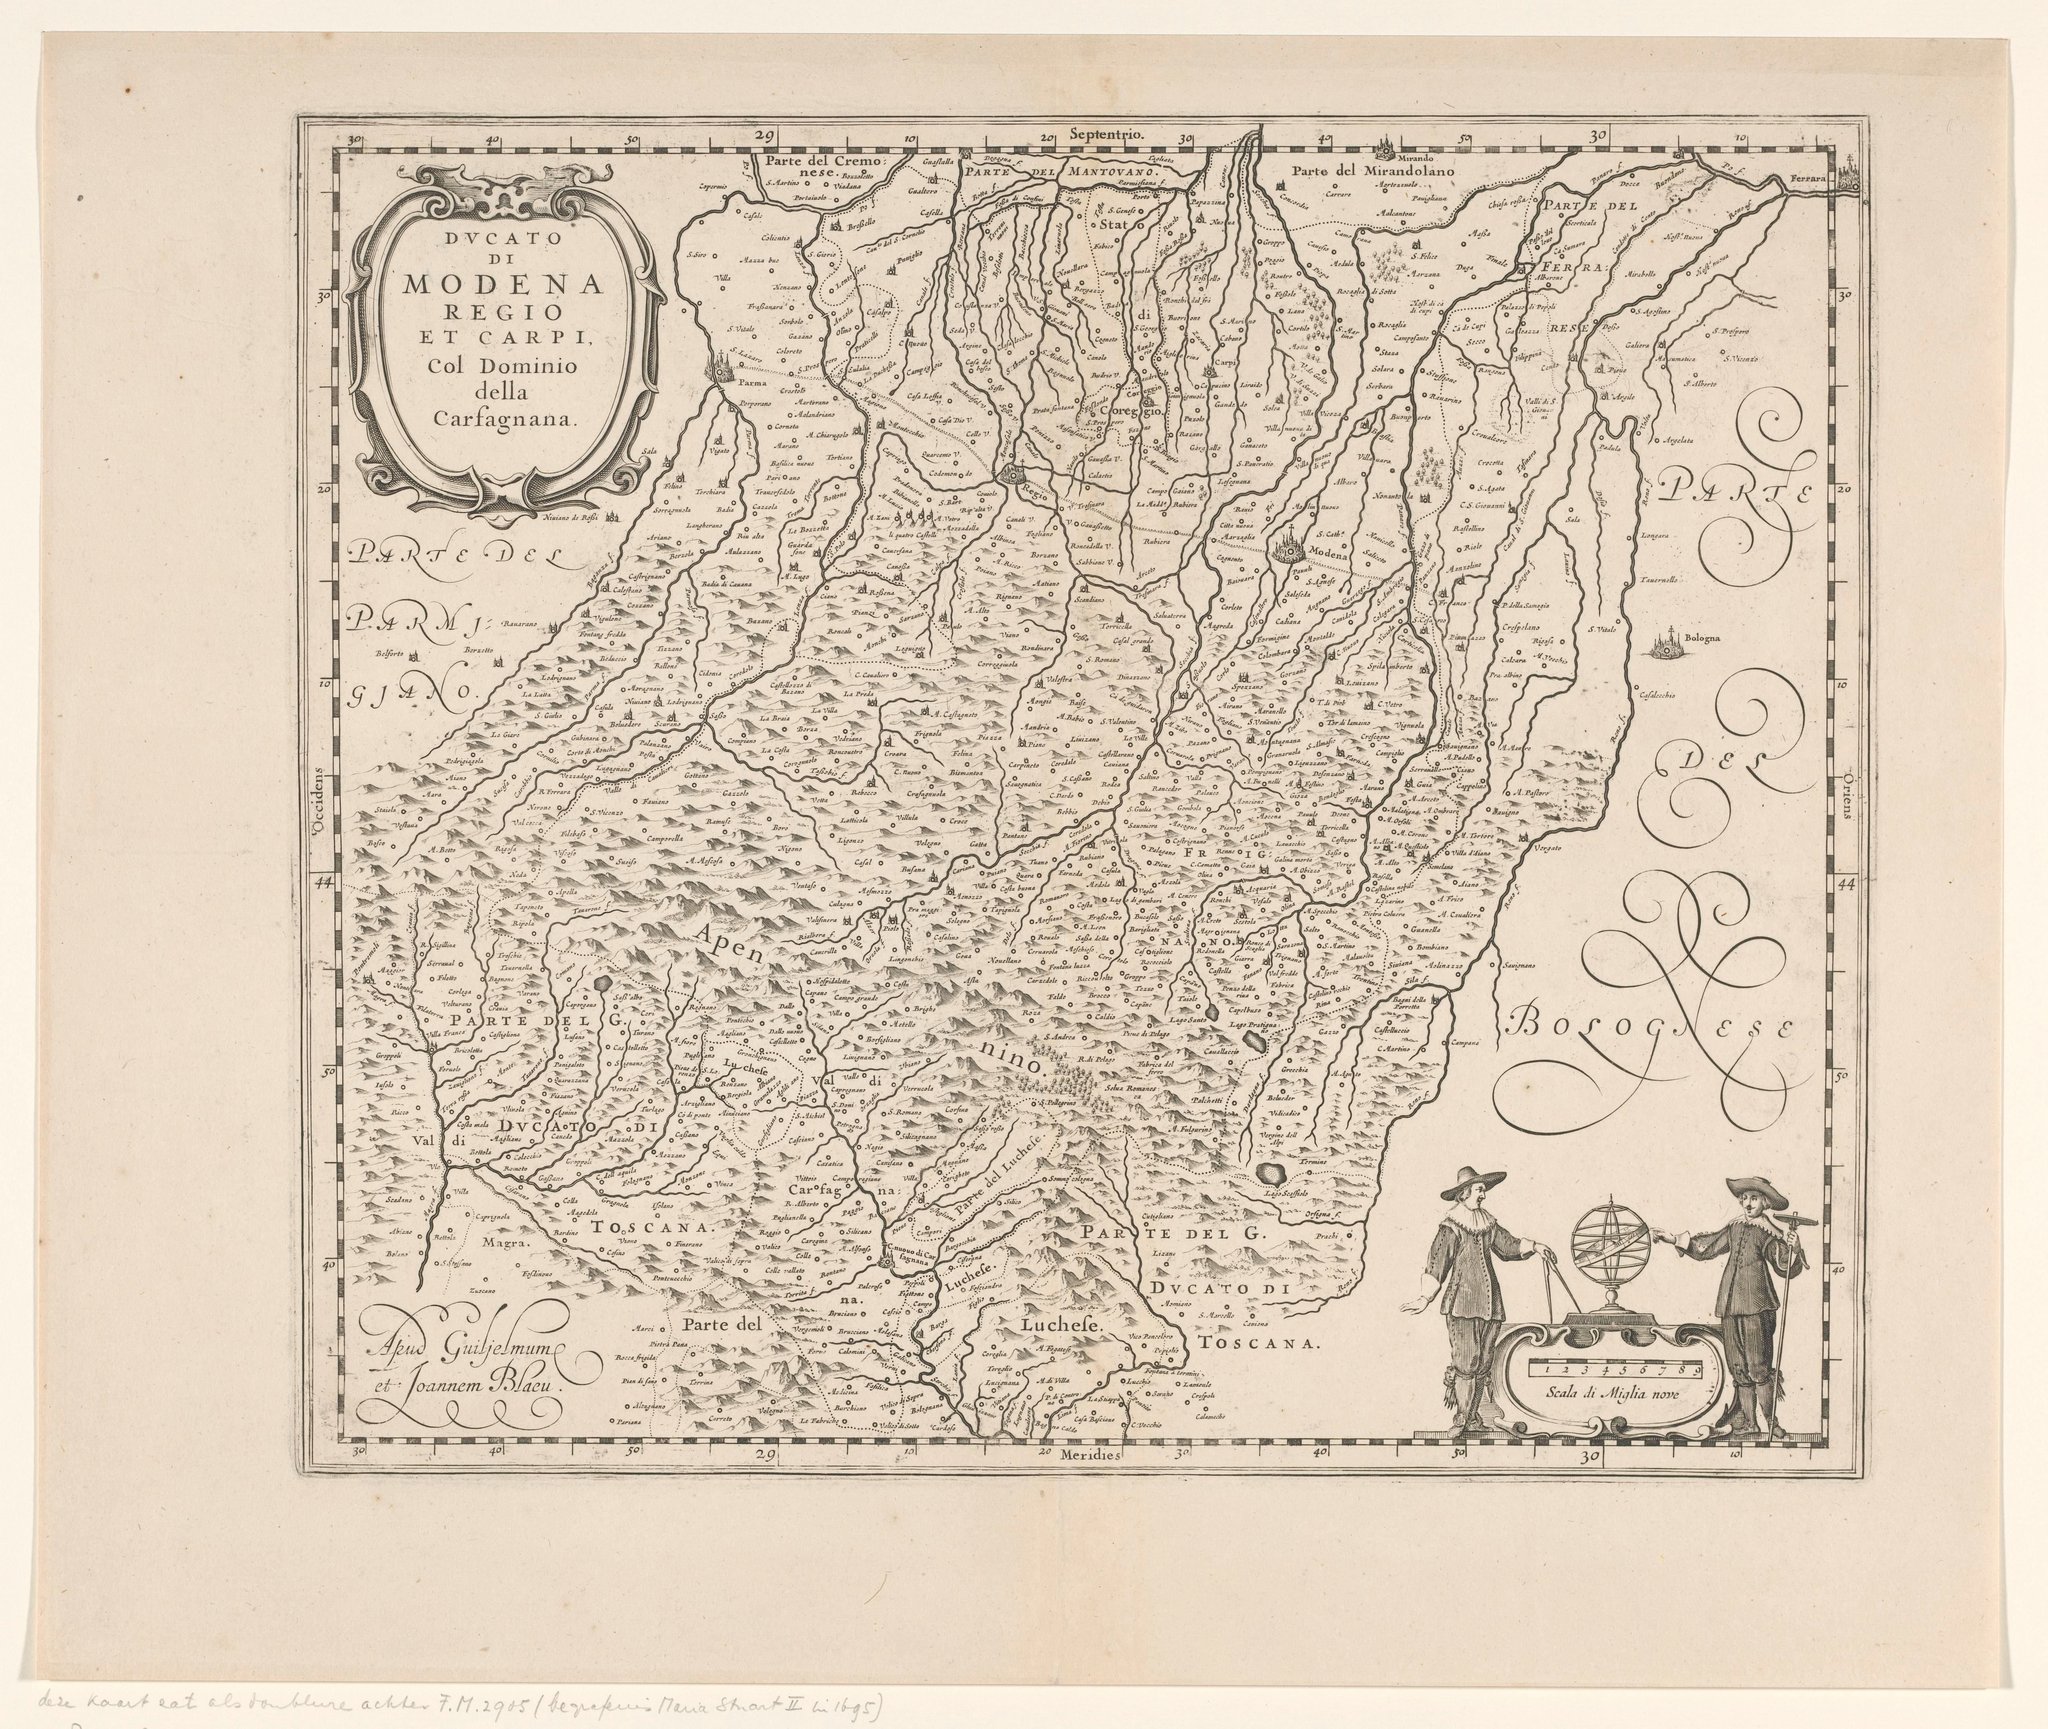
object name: print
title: Ducato di Modena regio et Carpi col dominio della carsagnana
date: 1640-1672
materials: paper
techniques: engraving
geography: amsterdam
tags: maps of separate countries or regions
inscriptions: collector's mark: Lugt 2228